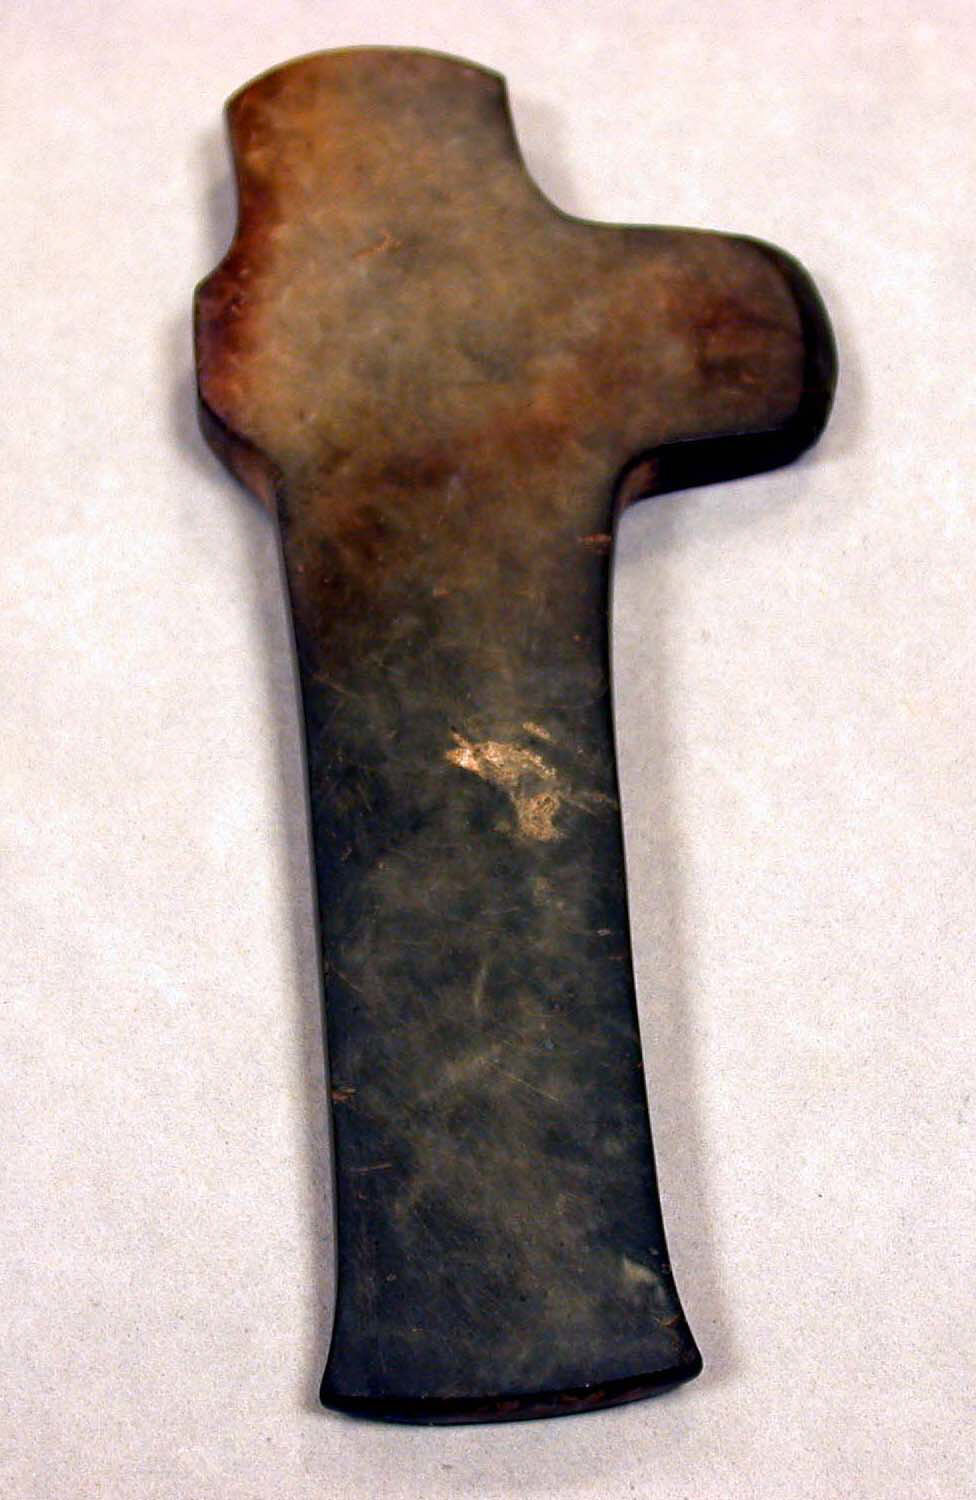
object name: axe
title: Ceremonial Stone Axe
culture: colombian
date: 1501-1600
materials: stone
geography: colombia